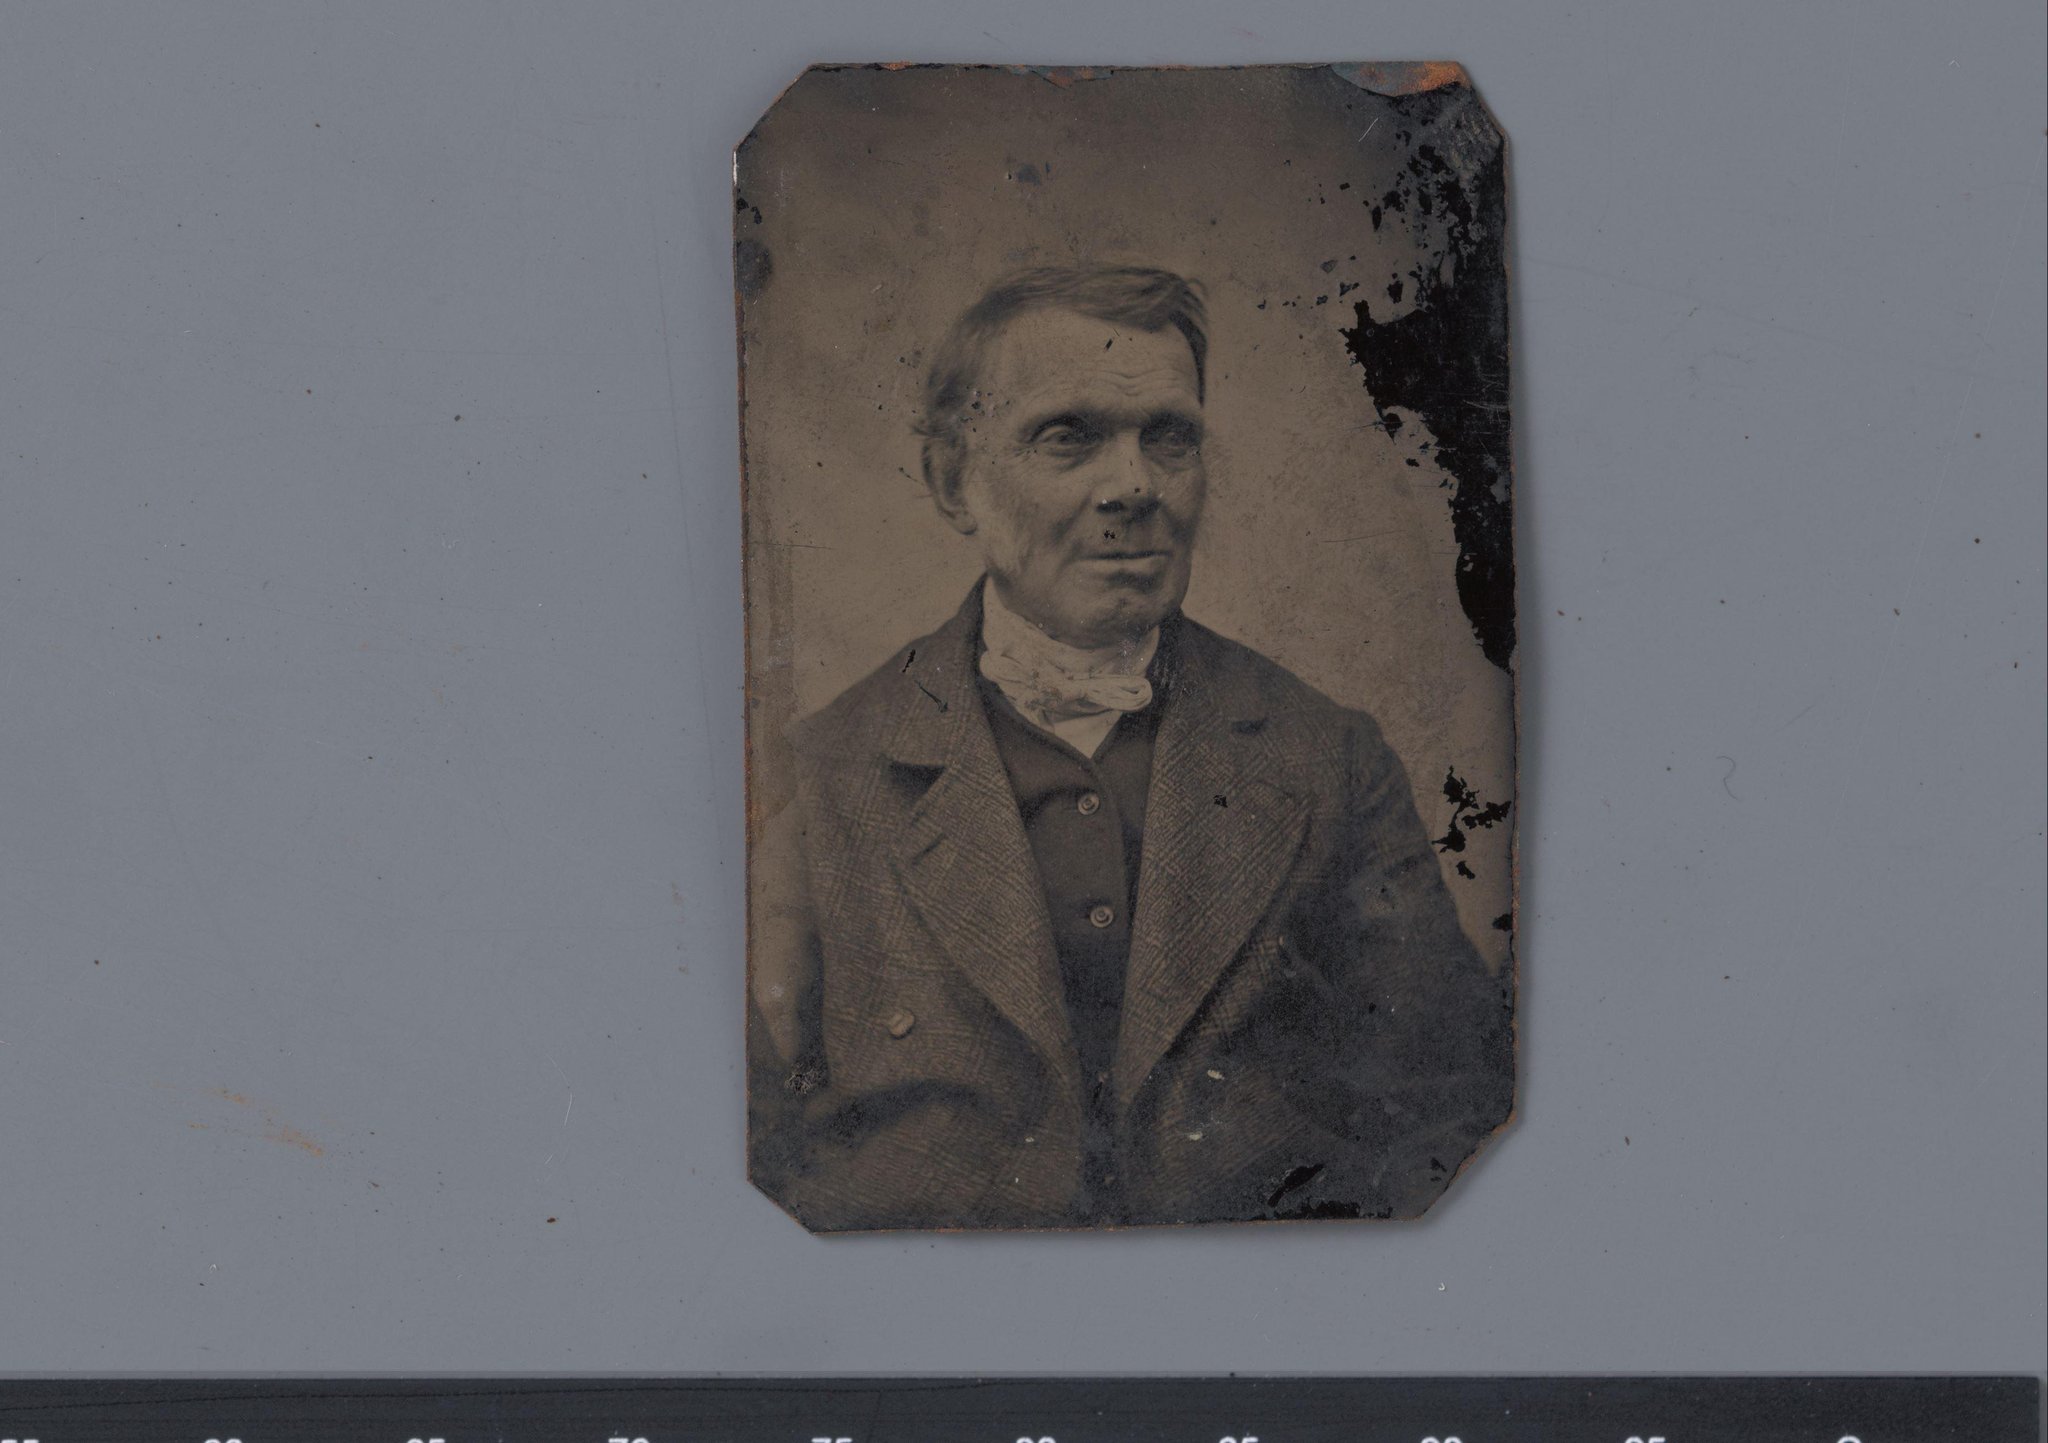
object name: photograph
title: Portret van een onbekende man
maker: Anonymous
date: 1855-1900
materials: iron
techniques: ferrotyping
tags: historical persons